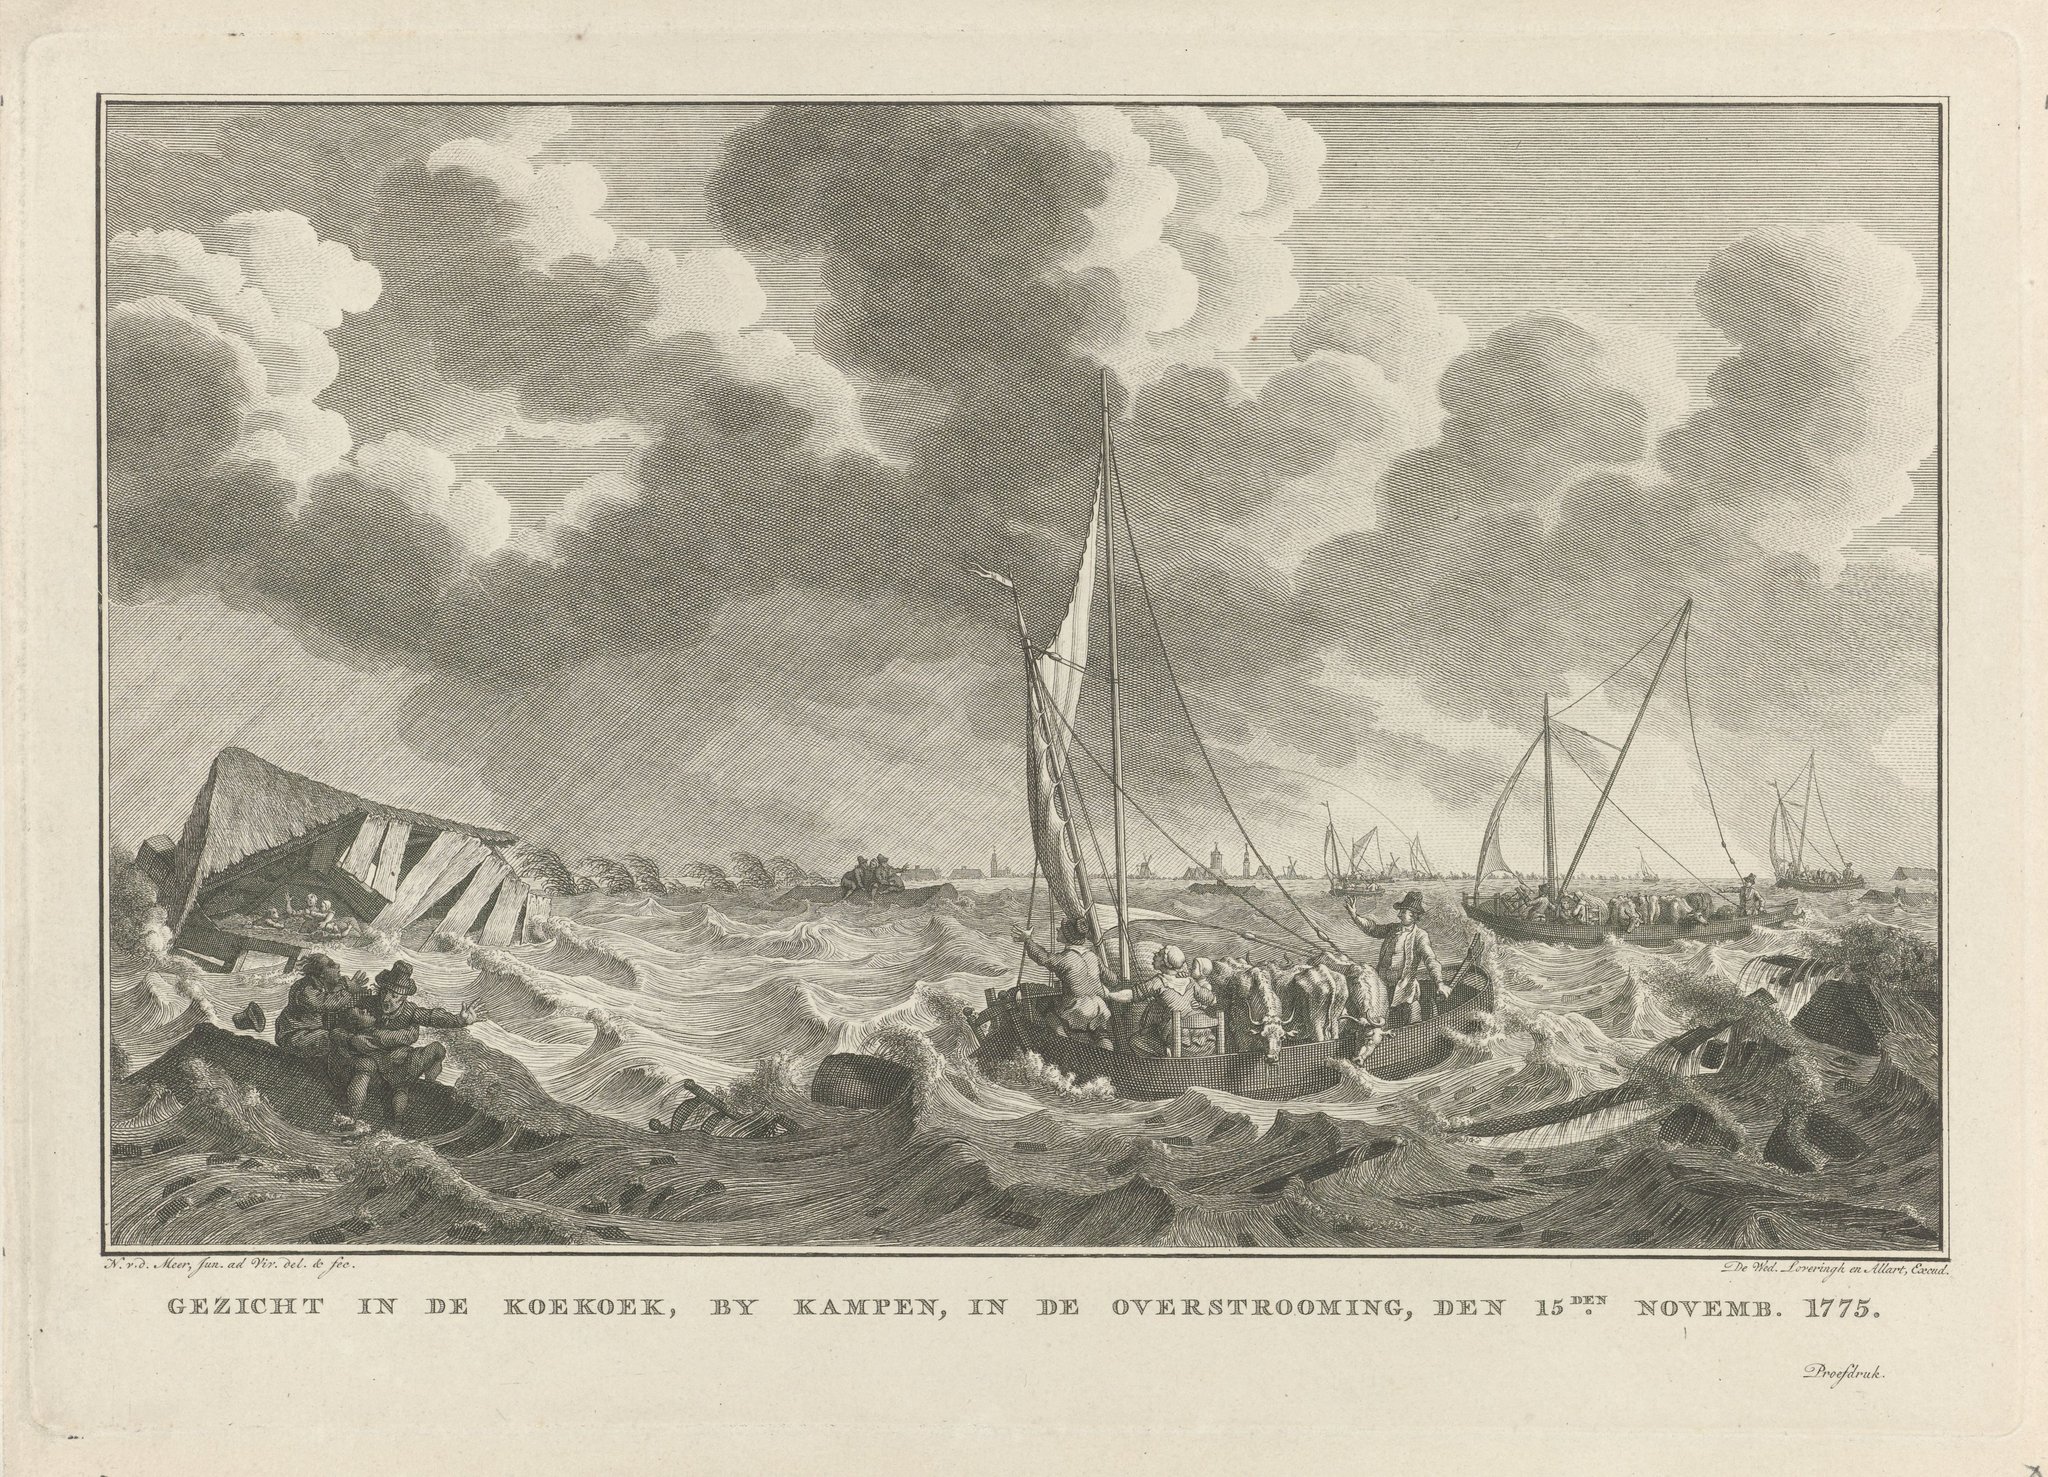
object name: print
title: Overstroming bij Kampen, 1775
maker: noach van der meer (ii)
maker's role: draughtsman, print maker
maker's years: 1741-1822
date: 1776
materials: paper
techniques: etching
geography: amsterdam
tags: rescue work during a flood, sailing-ship, sailing-boat, flood, the flood of 14-18 november 1775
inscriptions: collector's mark: Lugt 2228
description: Overstroming bij Kampen op 15 november 1775. Links bezwijkt een huis waarin een moeder met kind om hulp roept. Op de voorgrond zitten drie mensen op het dak van een huis. Zeilschepen proberen mensen en vee te redden. Aan de horizon de stad Kampen.